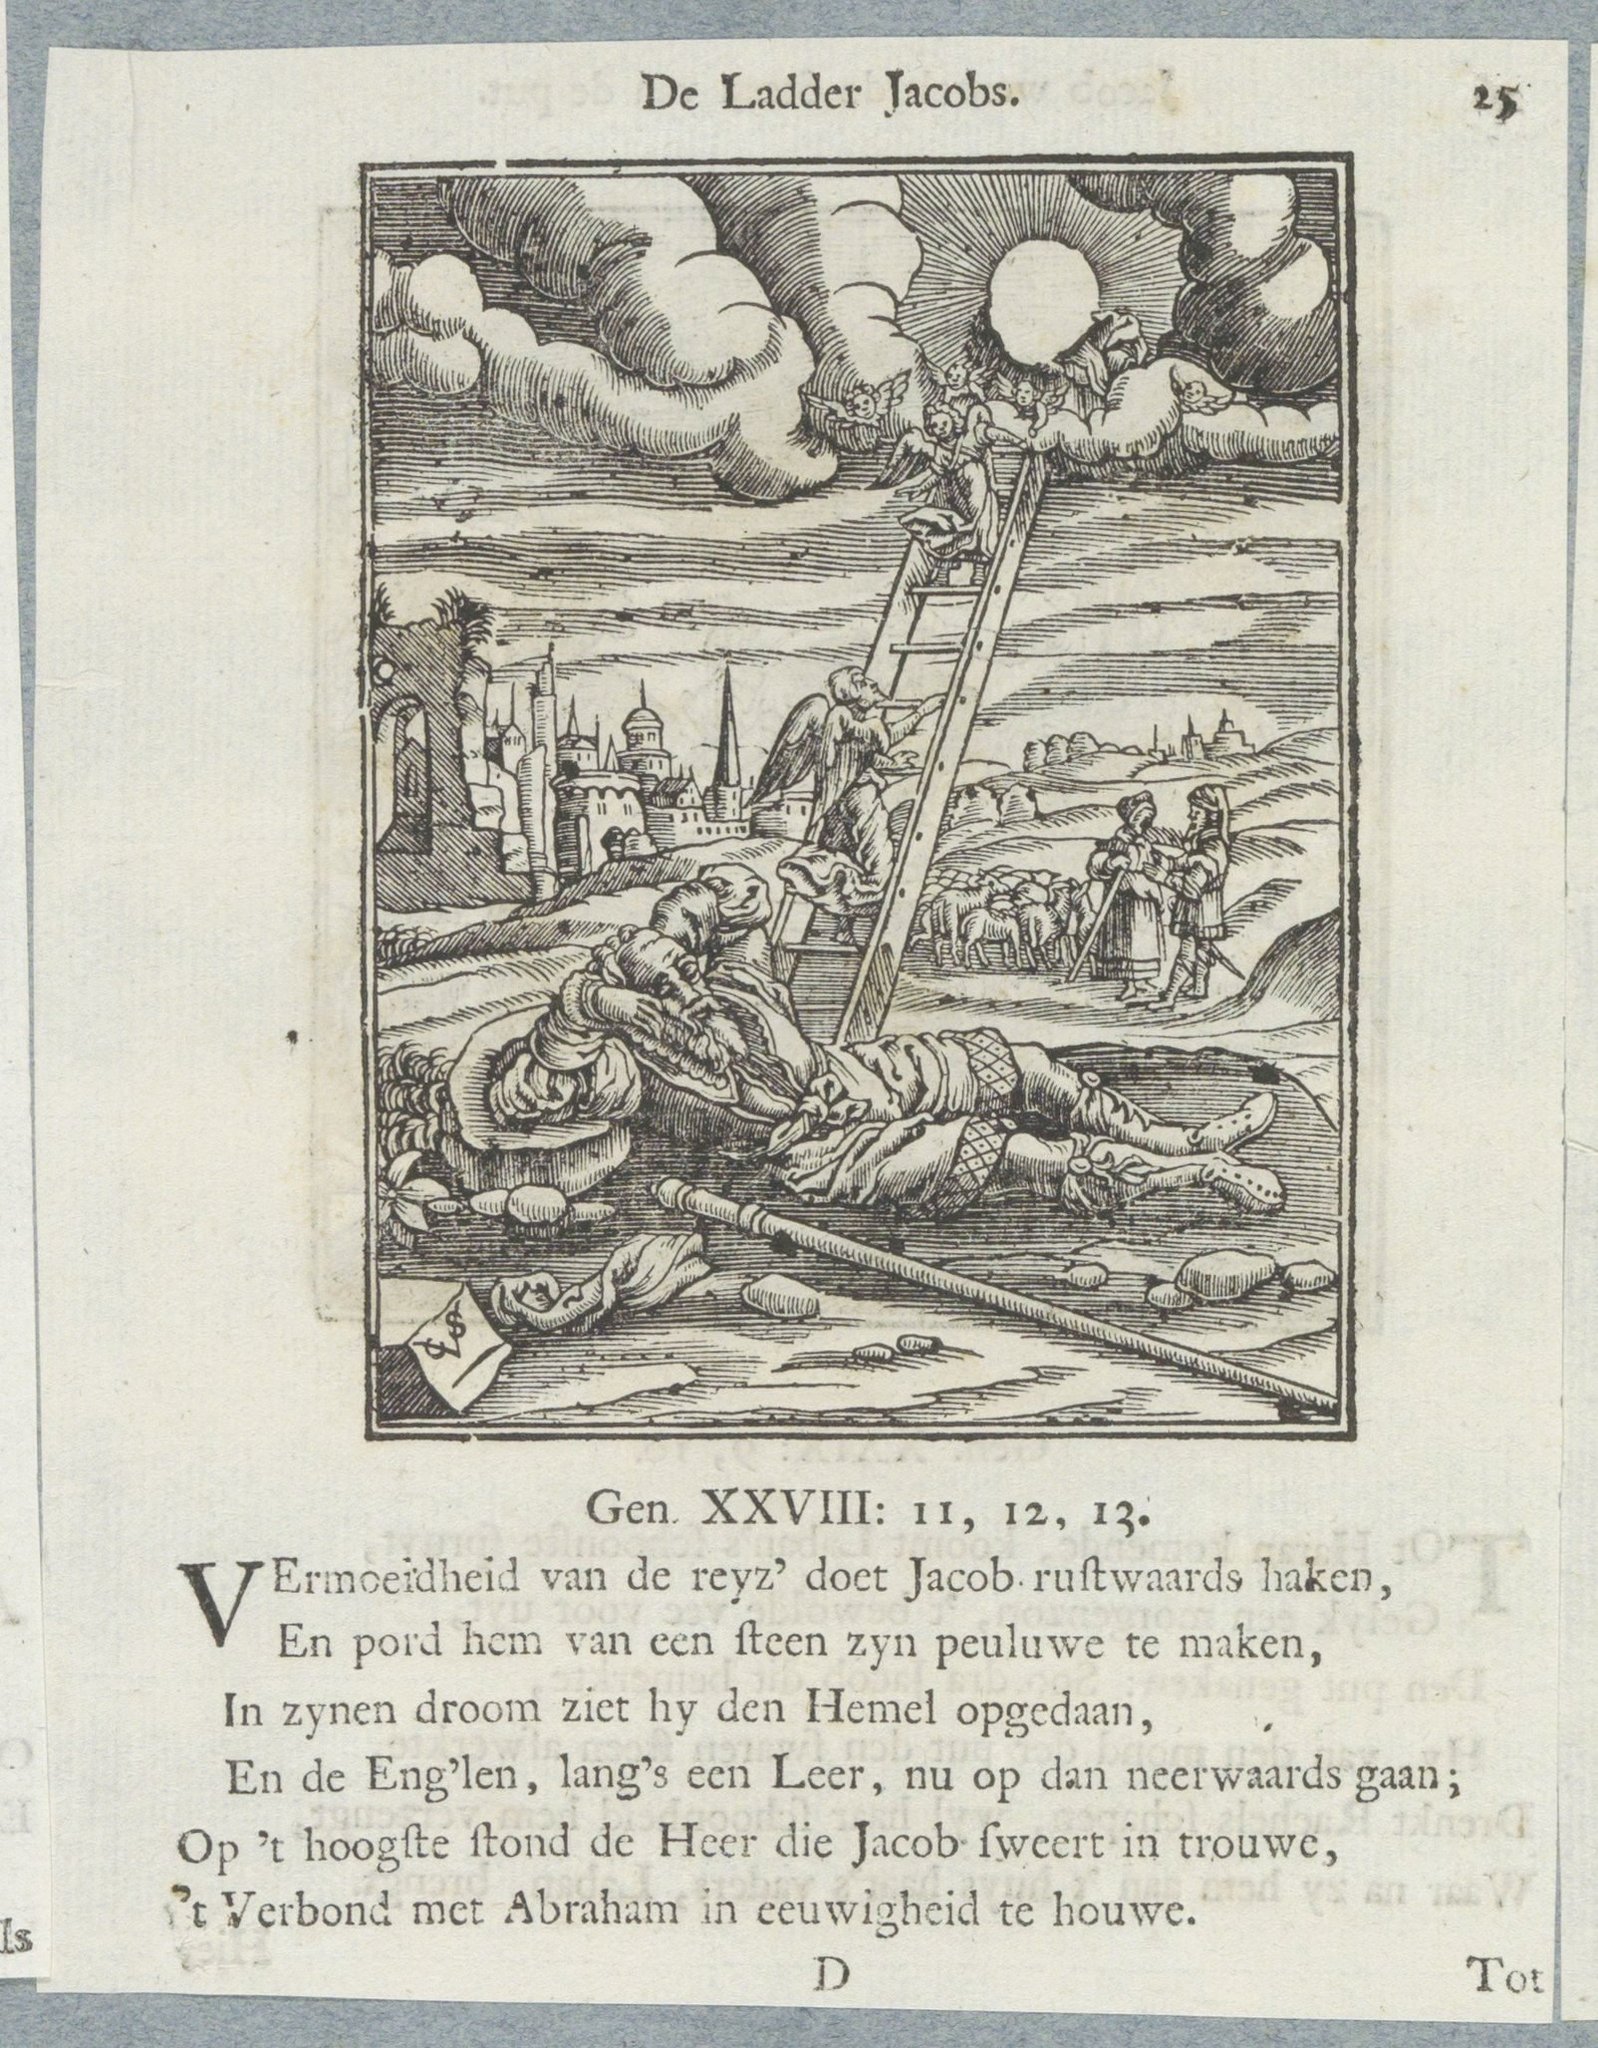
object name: album leaf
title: De ladder Jacobs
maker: jan klooster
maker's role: bookseller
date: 1645-1656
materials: paper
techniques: letterpress printing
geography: amsterdam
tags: the dream of jacob: while sleeping on the ground with a stone for pillow jacob sees a ladder reaching from earth to heaven with angels going up and down; usually with god at the top of the ladder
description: Van deze prenten zijn twee staten bekend. Op deze tweede staat is de afbeelding van God de Vader van de voorstelling verwijderd. De prent is afkomstig uit: Bybels Lusthof. Amsterdam, J. Klooster, 1740. De prent werd gemaakt voor de uitgaven van P.J. Paets uit Amsterdam. Ze komt in ieder geval voor in: Bibels Tresoor ofte der zielen lusthof. Amsterdam, P.J. Paets, 1646. Mogelijk staat ze ook in: Historien ende Prophetien. [Amsterdam], P.J. Paets, 1645.